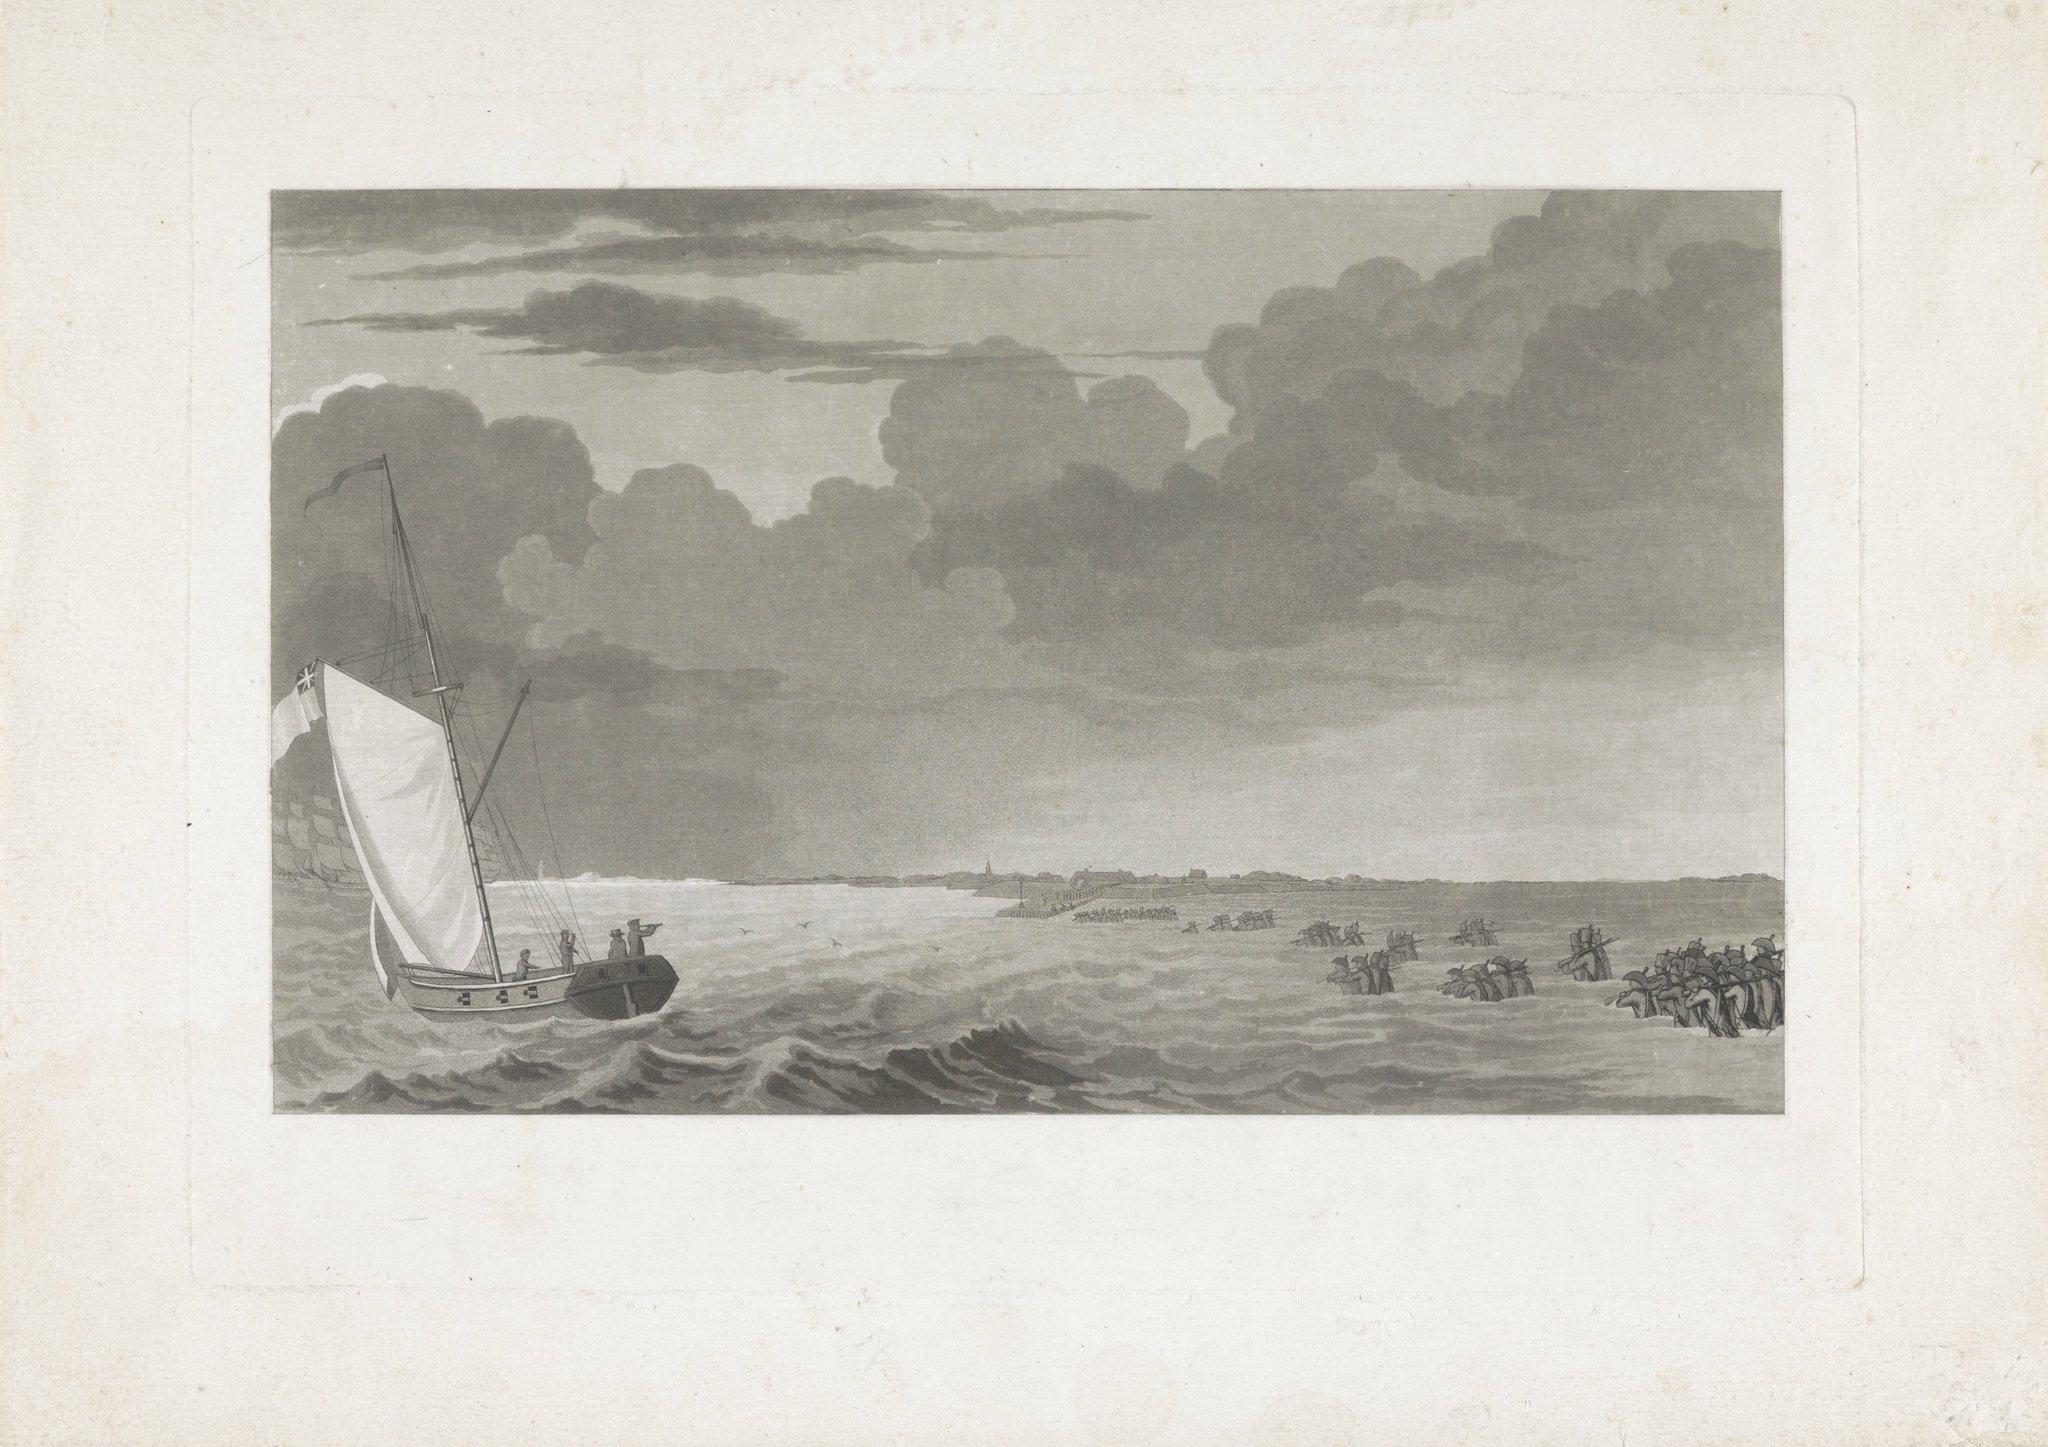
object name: print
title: Herovering van Fort Bath, 1809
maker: friedrich christoph dietrich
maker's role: print maker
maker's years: 1779-1847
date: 1809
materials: paper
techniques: aquatint, etching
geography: netherlands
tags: deventer, bombardment (+ sailing-ships)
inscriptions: collector's mark: Lugt 2228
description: Herovering van het door de Britten bezette fort Bath, 4 september 1809. Nederlandse troepen onder bevel van generaal Cort Heijligers waden door het water van de Kreekrak naar het fort.